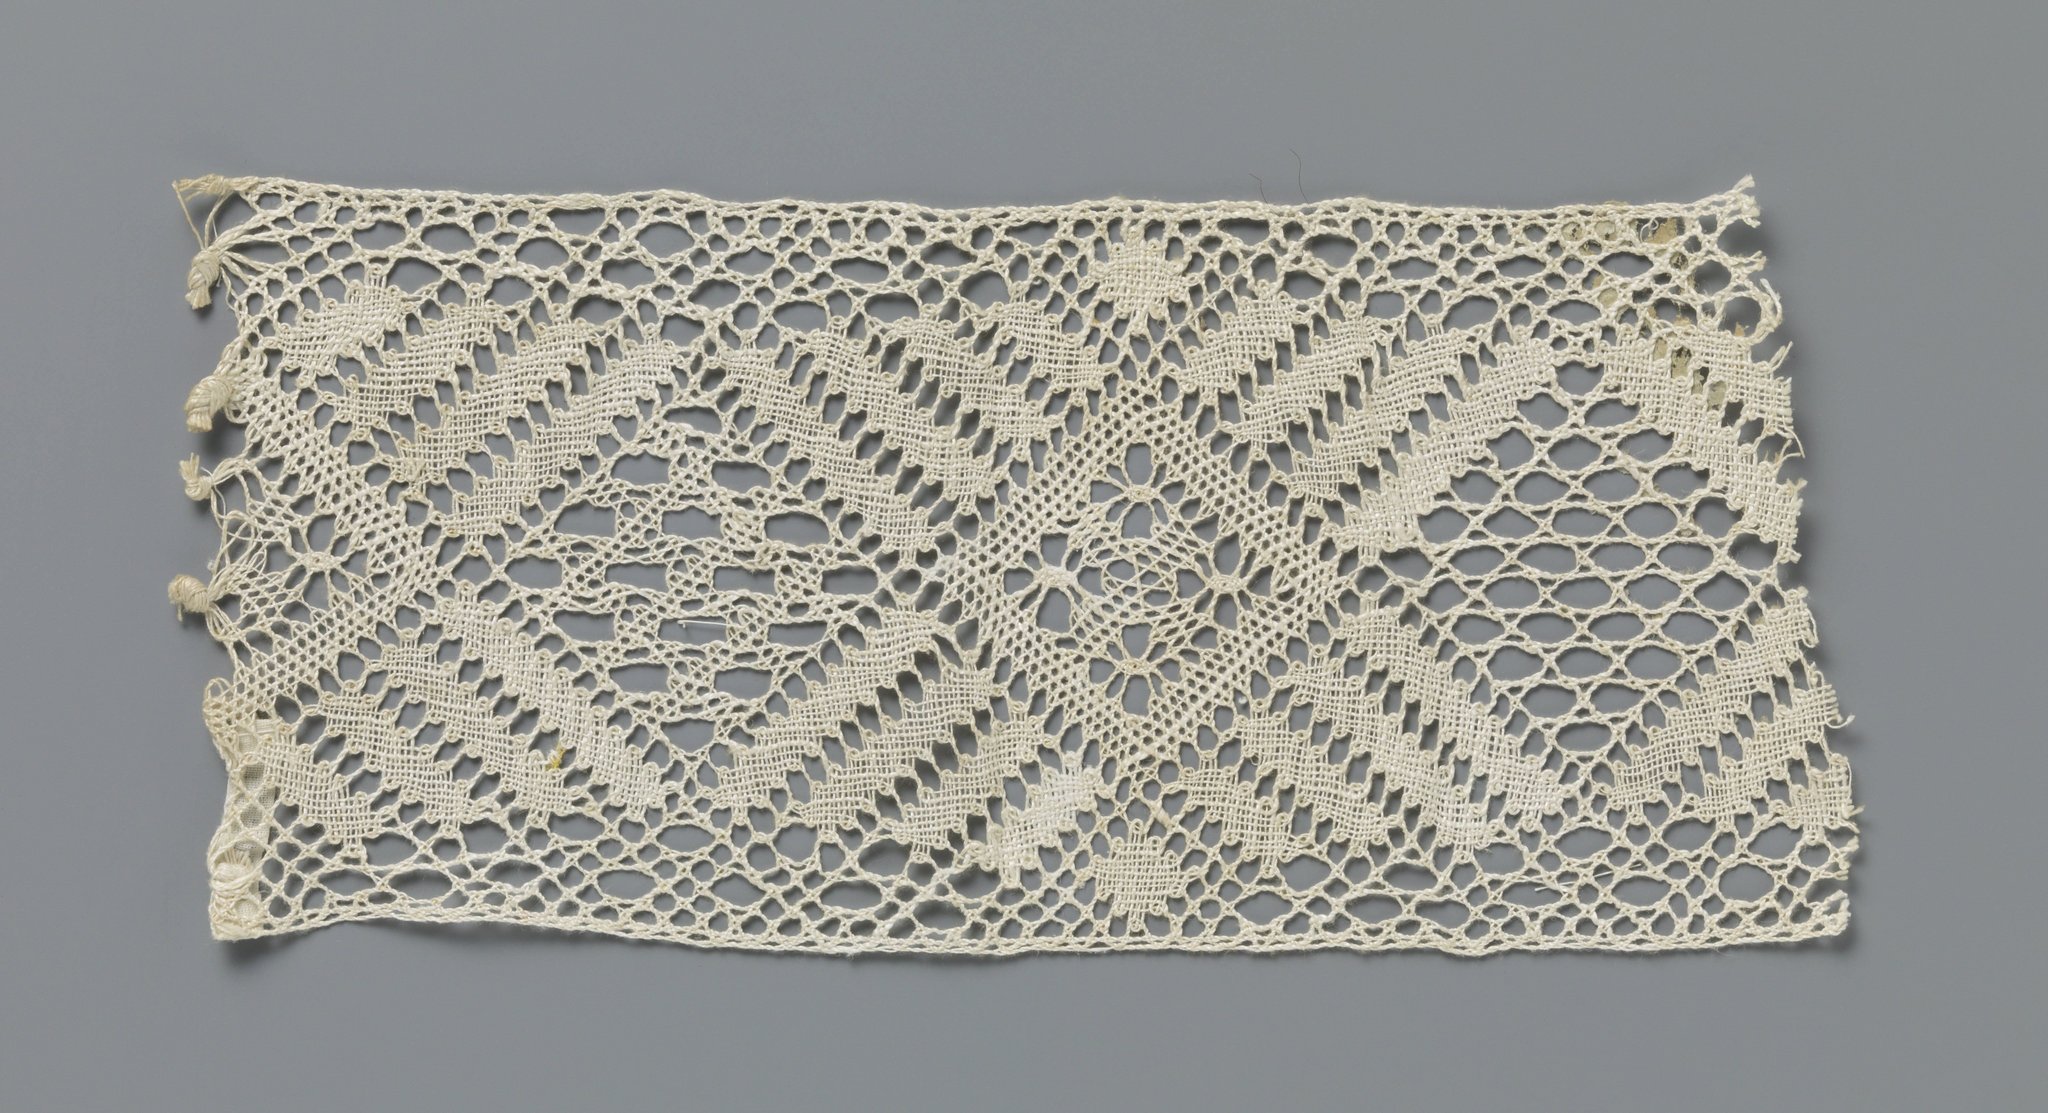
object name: entre deux, tussenzetsel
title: Tussenzetsel van kloskant met een rij ruiten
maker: Anonymous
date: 1900-1924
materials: linen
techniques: lace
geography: russia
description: Tussenzetsel van naturelkleurig kloskant: stropkant. Het zich herhalende patroon bestaat uit een rij aaneengeschakelde ruiten. De ruiten hebben afwisselend contouren in linnenslag en netslag en verschillende siergronden als vulling. De contouren in linnenslag worden op de hoekpunten onderbroken en parallel aan elke zijde staan drie lijnen in linnenslag. Deze lijnen vullen de velden tussen de ruiten op. Boven- en onderzijde van de strook zijn recht afgewerkt.